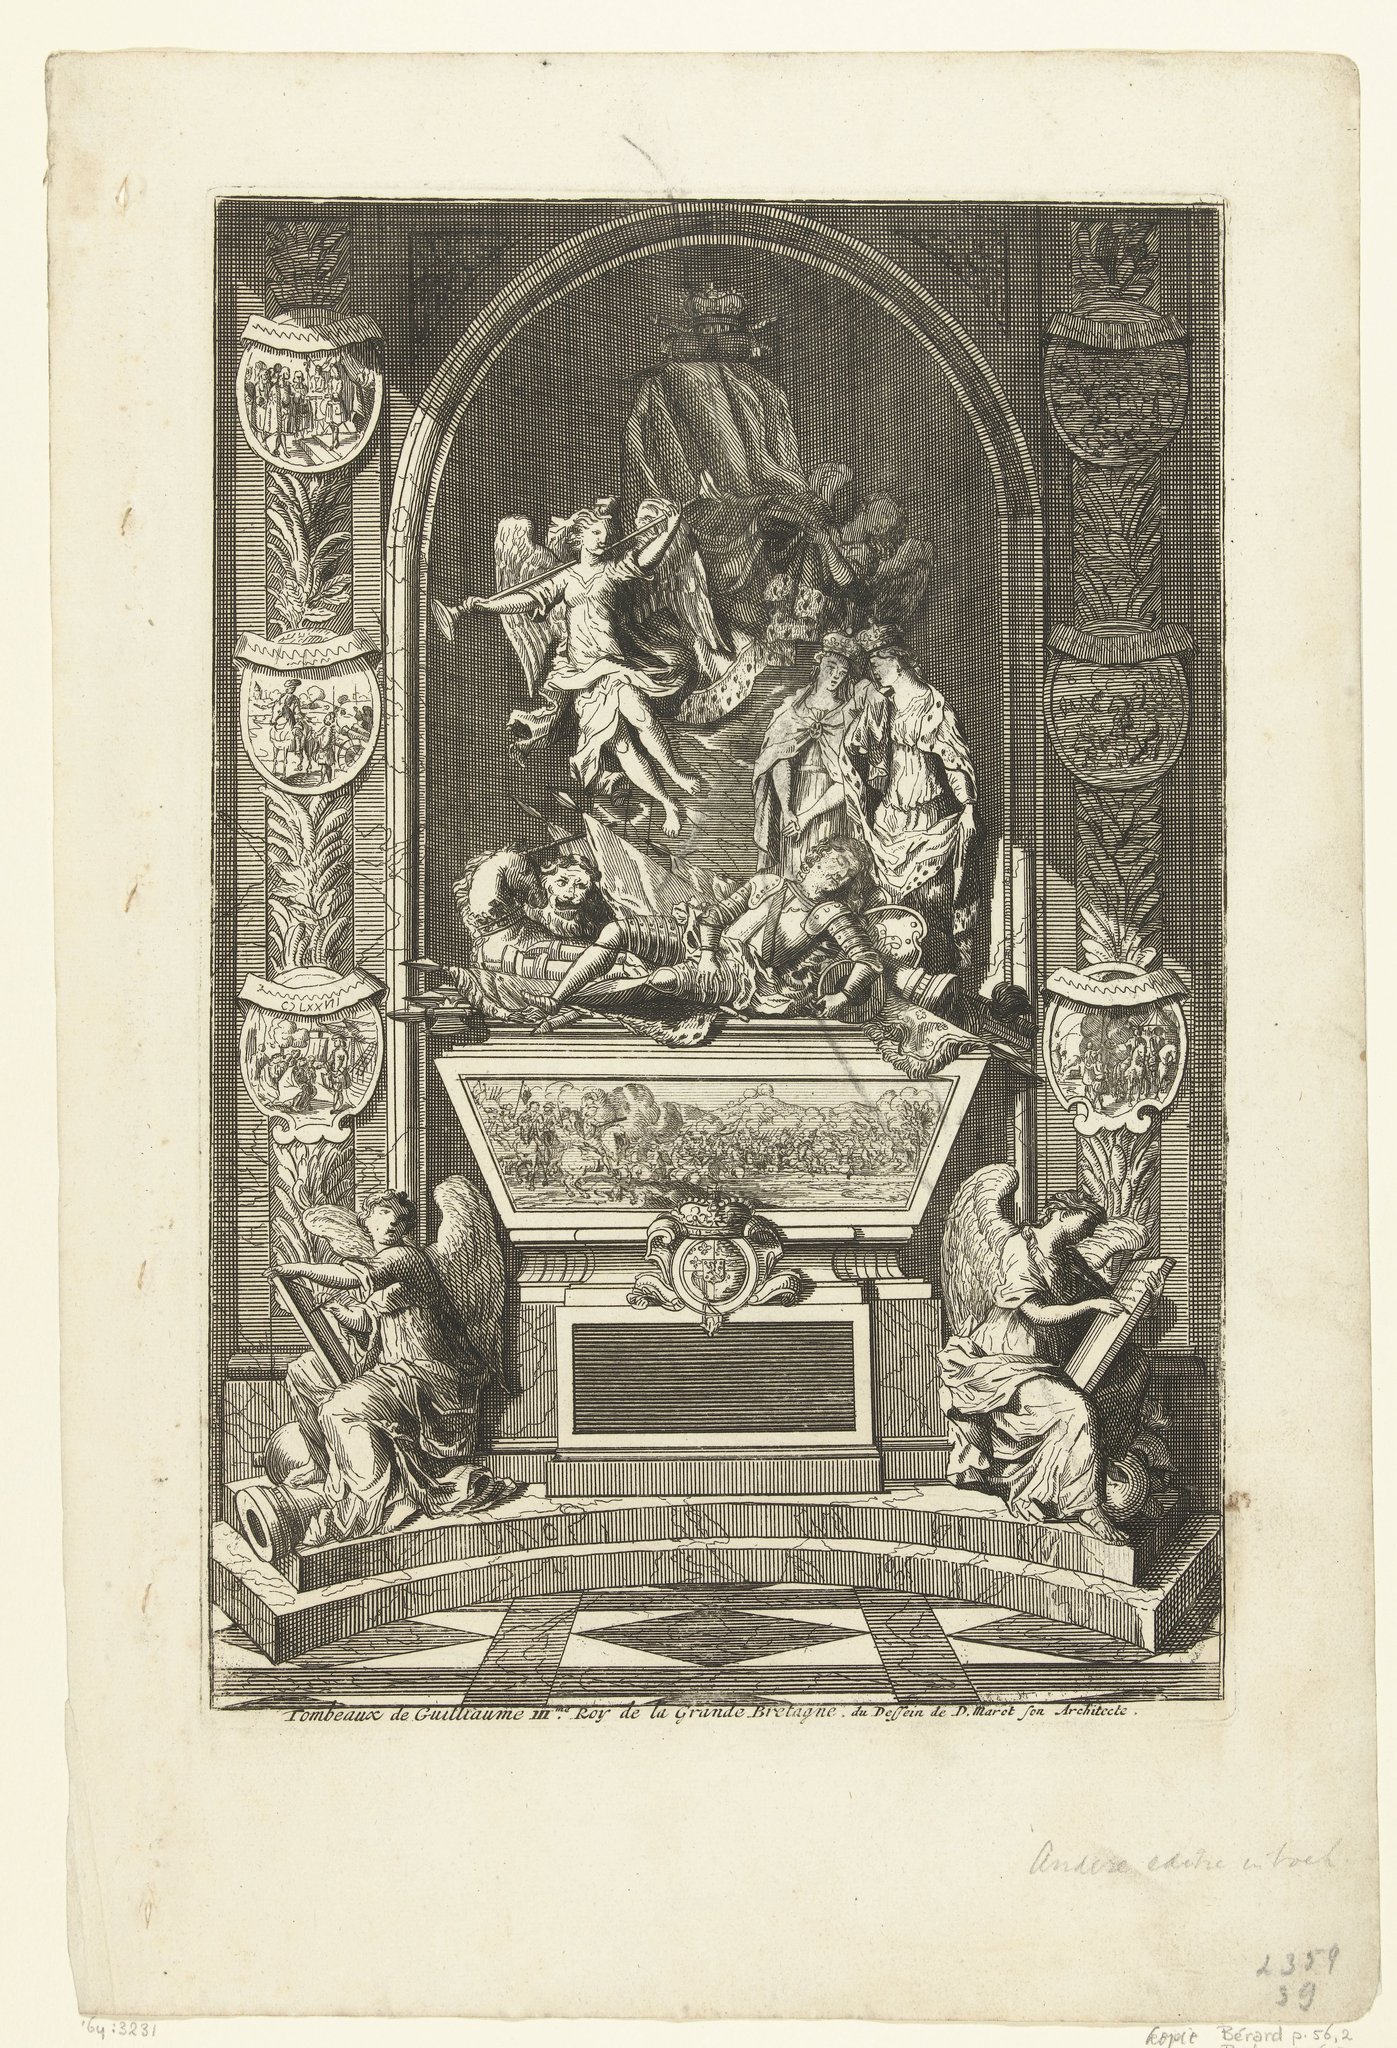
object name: ornament print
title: Tombeaux de Guillaume III.me Roy de la Grande Bretagne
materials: paper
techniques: etching